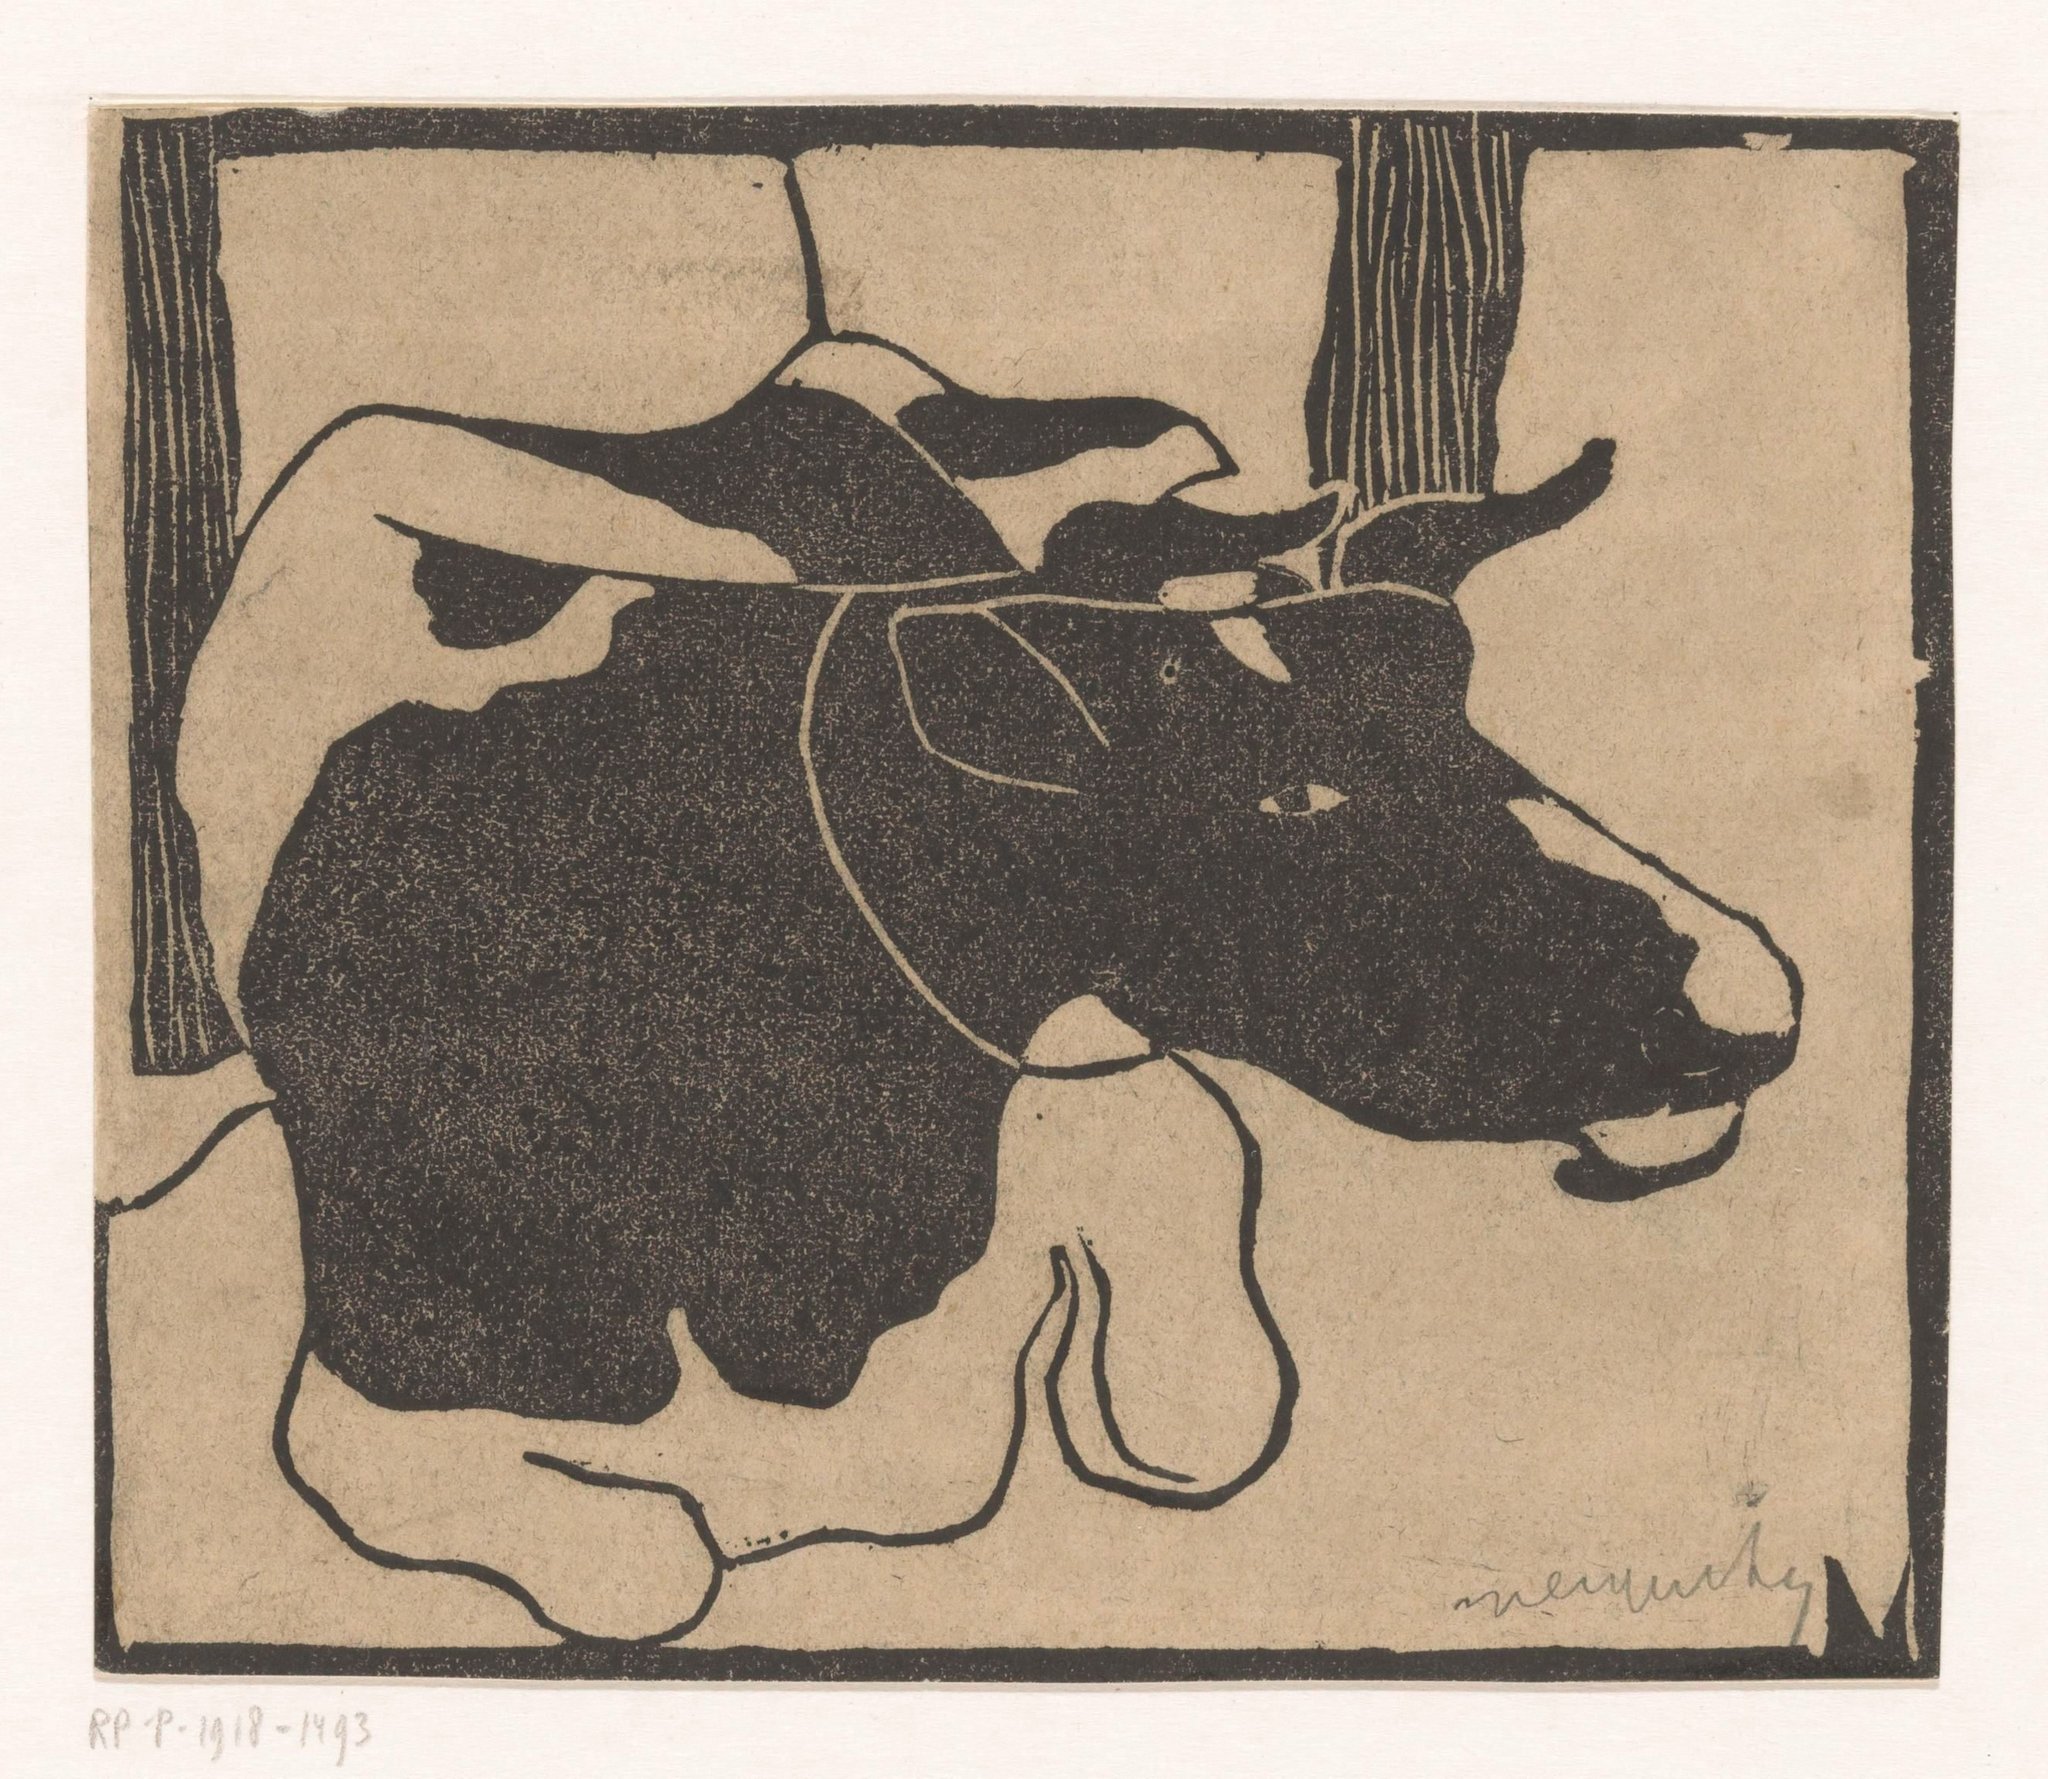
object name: print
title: Liggende koe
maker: samuel jessurun de mesquita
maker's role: draughtsman, print maker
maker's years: 1868-1944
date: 1900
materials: paper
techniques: woodcut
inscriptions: signature: ‘mesquita’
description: Liggende koe (lijf van voren, kop opzij).